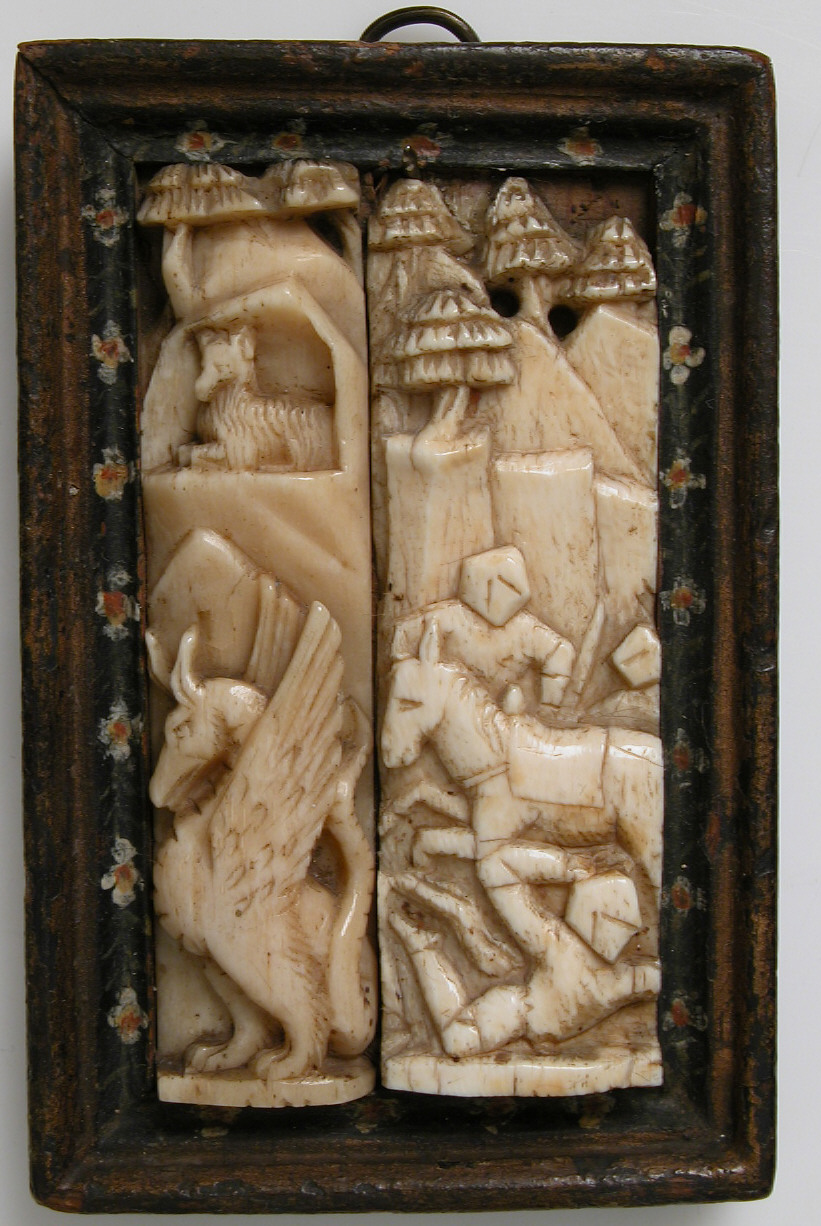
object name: relief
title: Fragments of a Box representing the Quest for the Golden Fleece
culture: north italian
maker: embriachi workshop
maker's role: artist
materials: bone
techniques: painting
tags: soldiers,griffins,horses